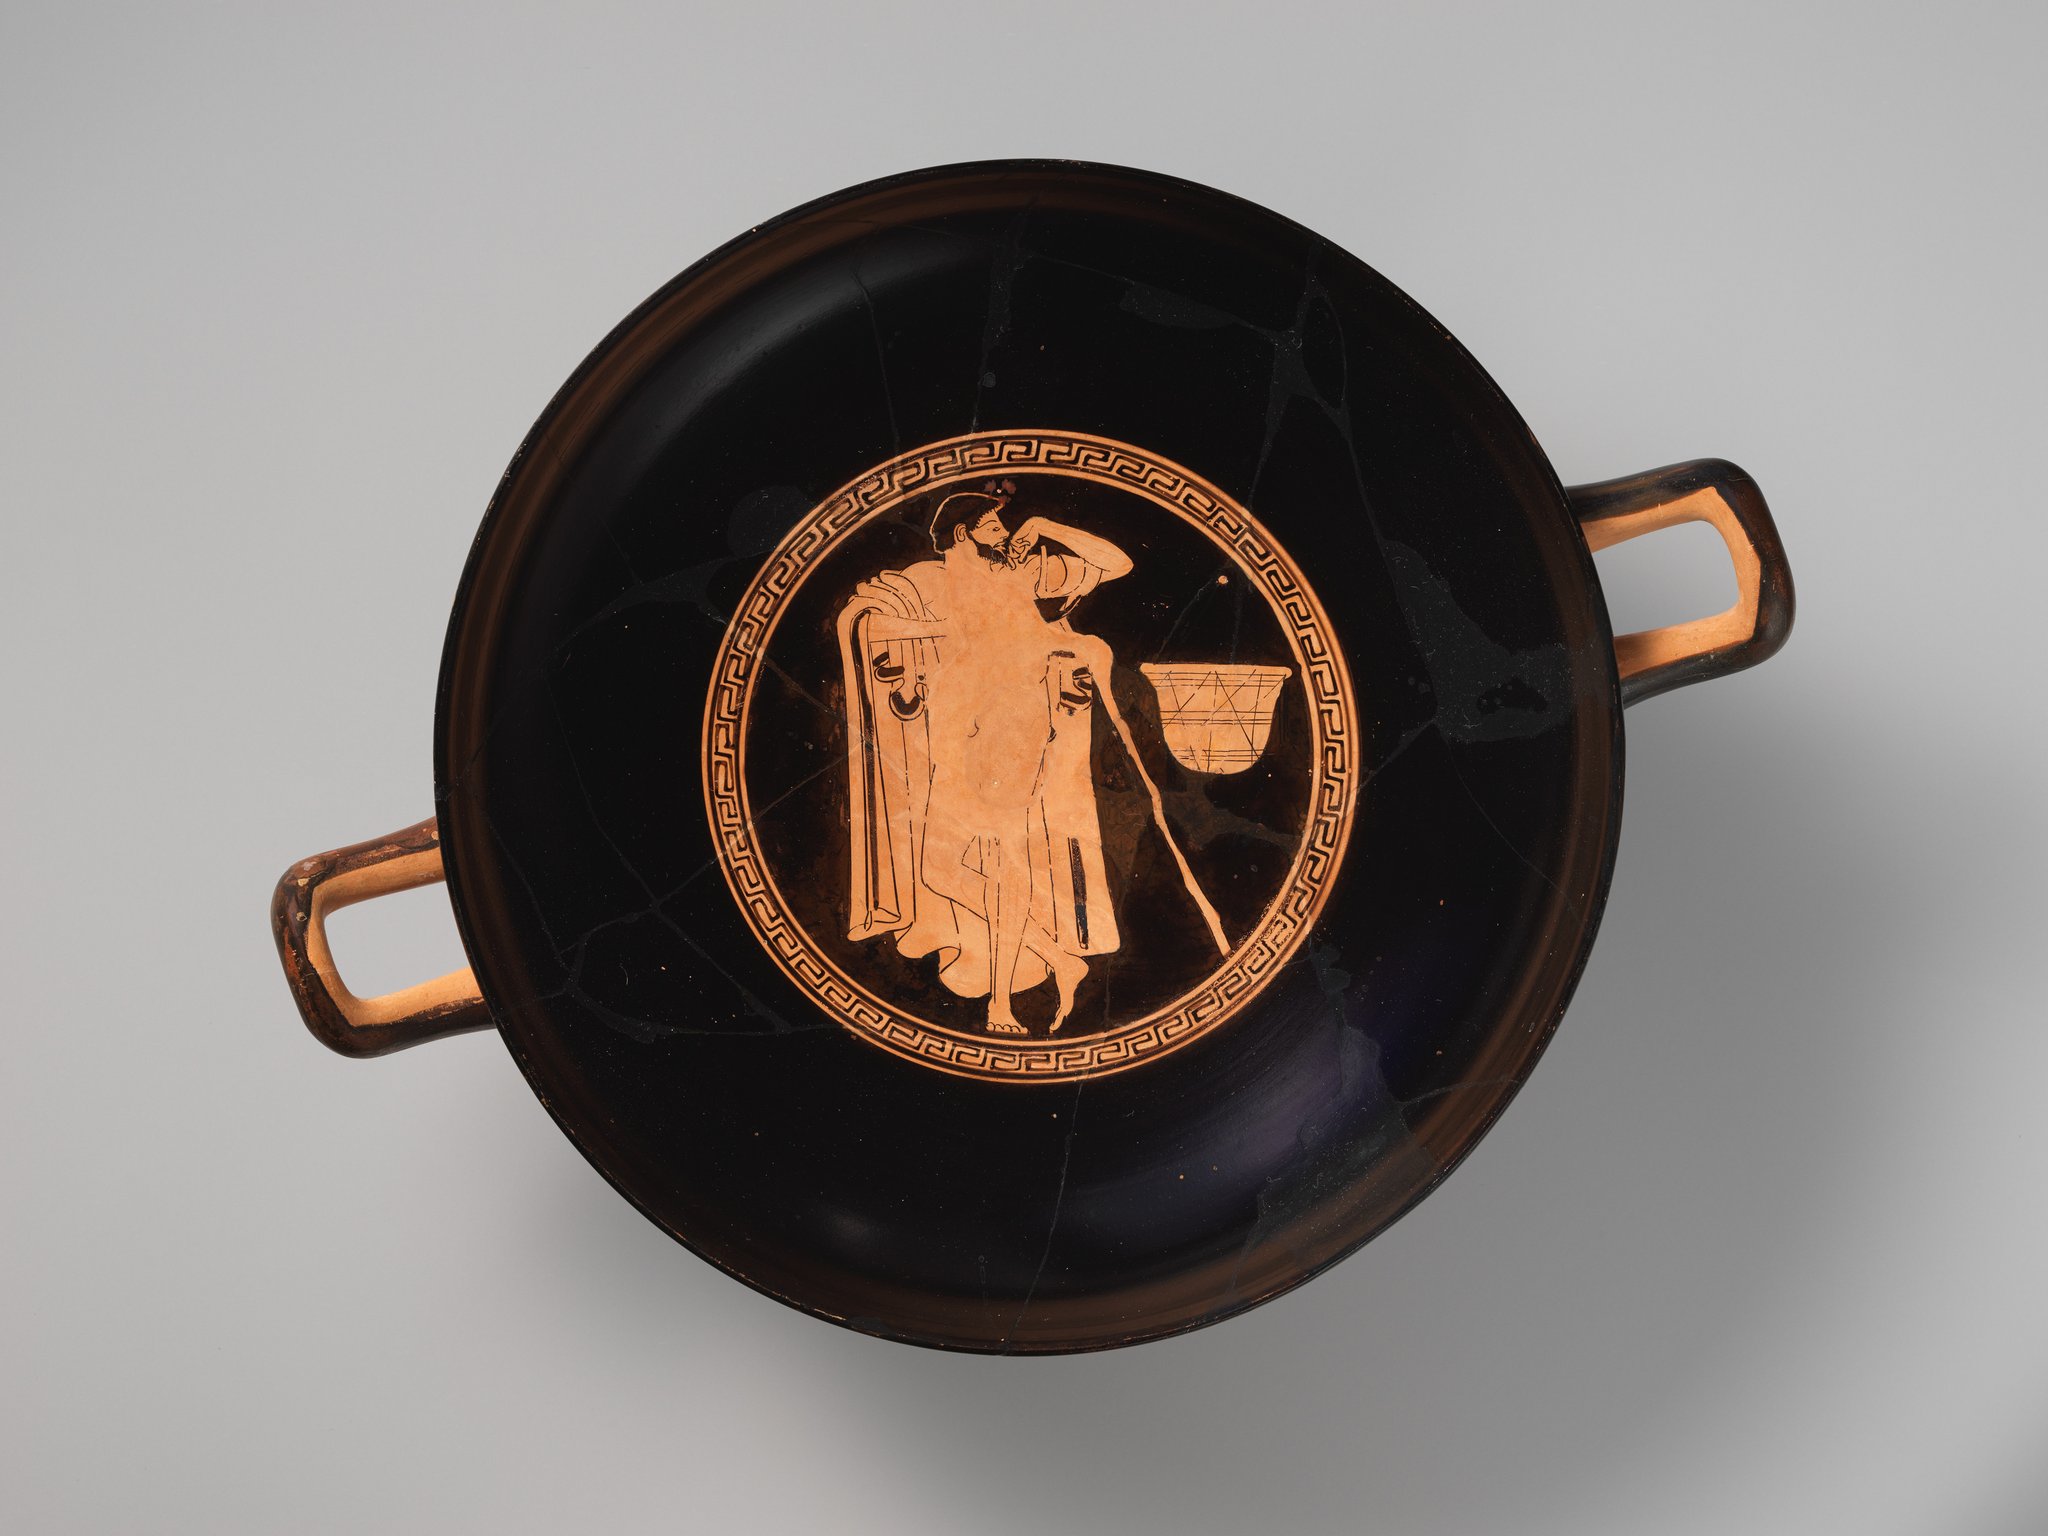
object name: kylix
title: Terracotta kylix (drinking cup)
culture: greek, attic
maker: brygos painter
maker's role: artist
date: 490-480 BCE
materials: terracotta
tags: men